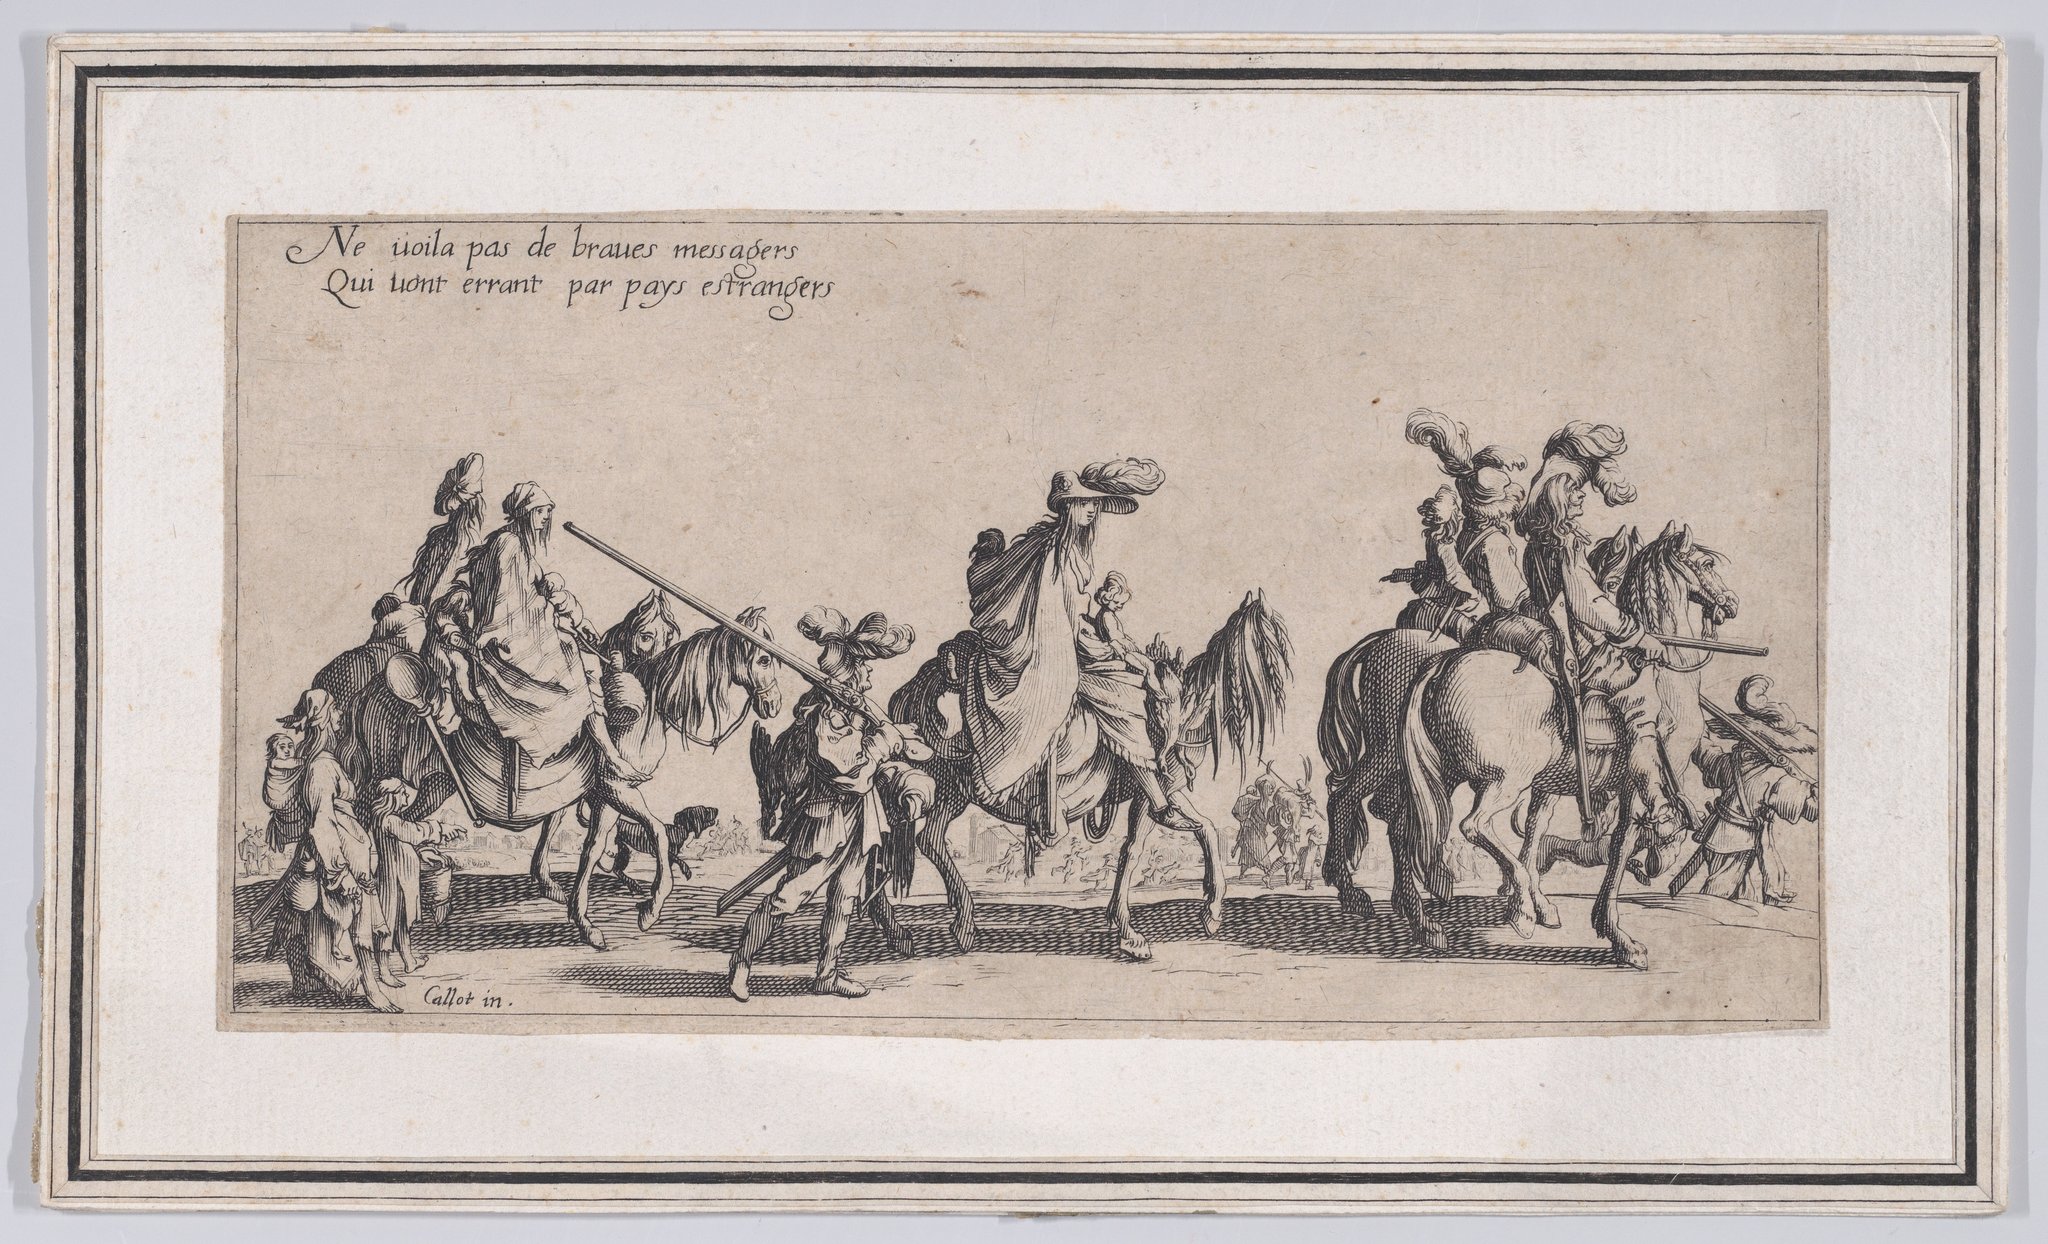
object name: print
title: Copy of Les Bohémiens en Marche, pièce aussi appelée L'Avant-Garde (The Gypsies Travelling, piece also called The Advance Gard), from "Le Bohémiens..."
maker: Anonymous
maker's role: artist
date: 1601-1700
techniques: engraving, etching